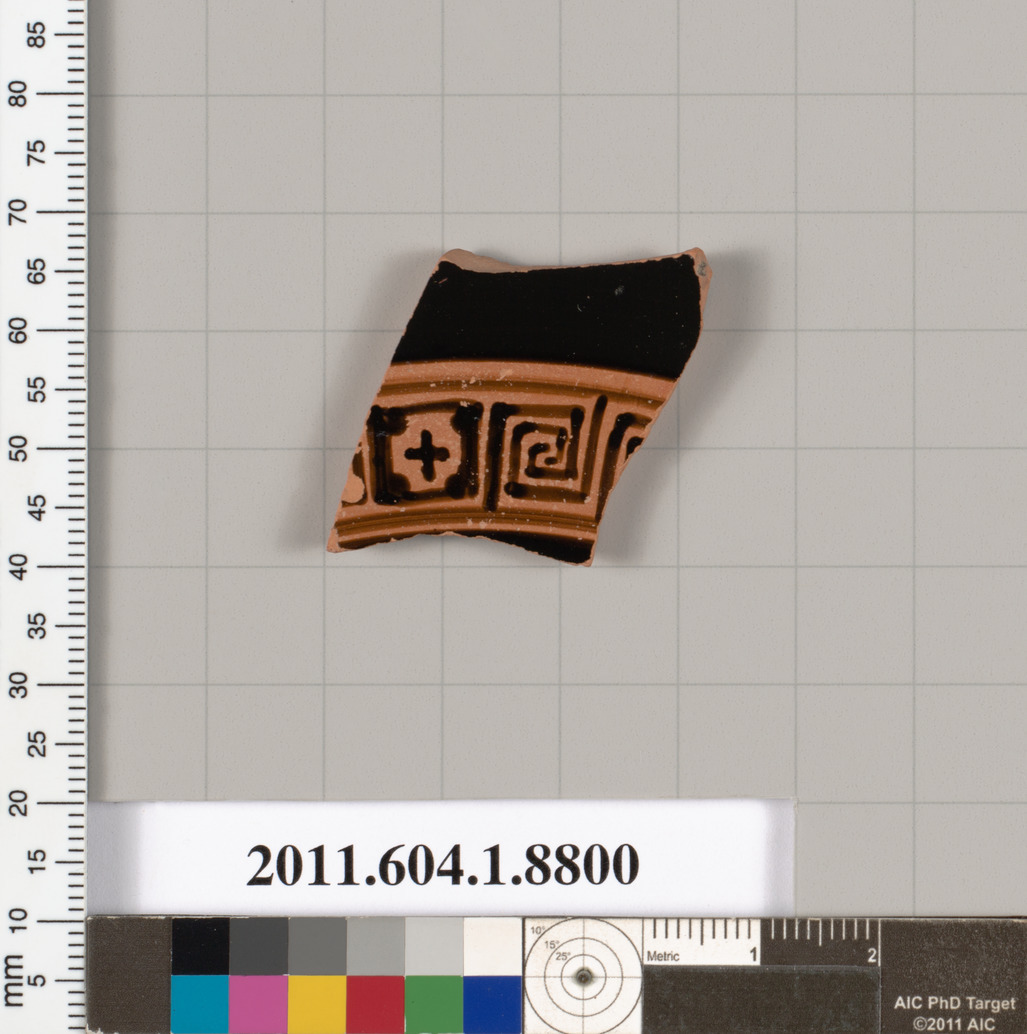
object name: kylix fragment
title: Terracotta fragment of a kylix (drinking cup)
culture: greek, attic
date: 490-480 BCE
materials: terracotta